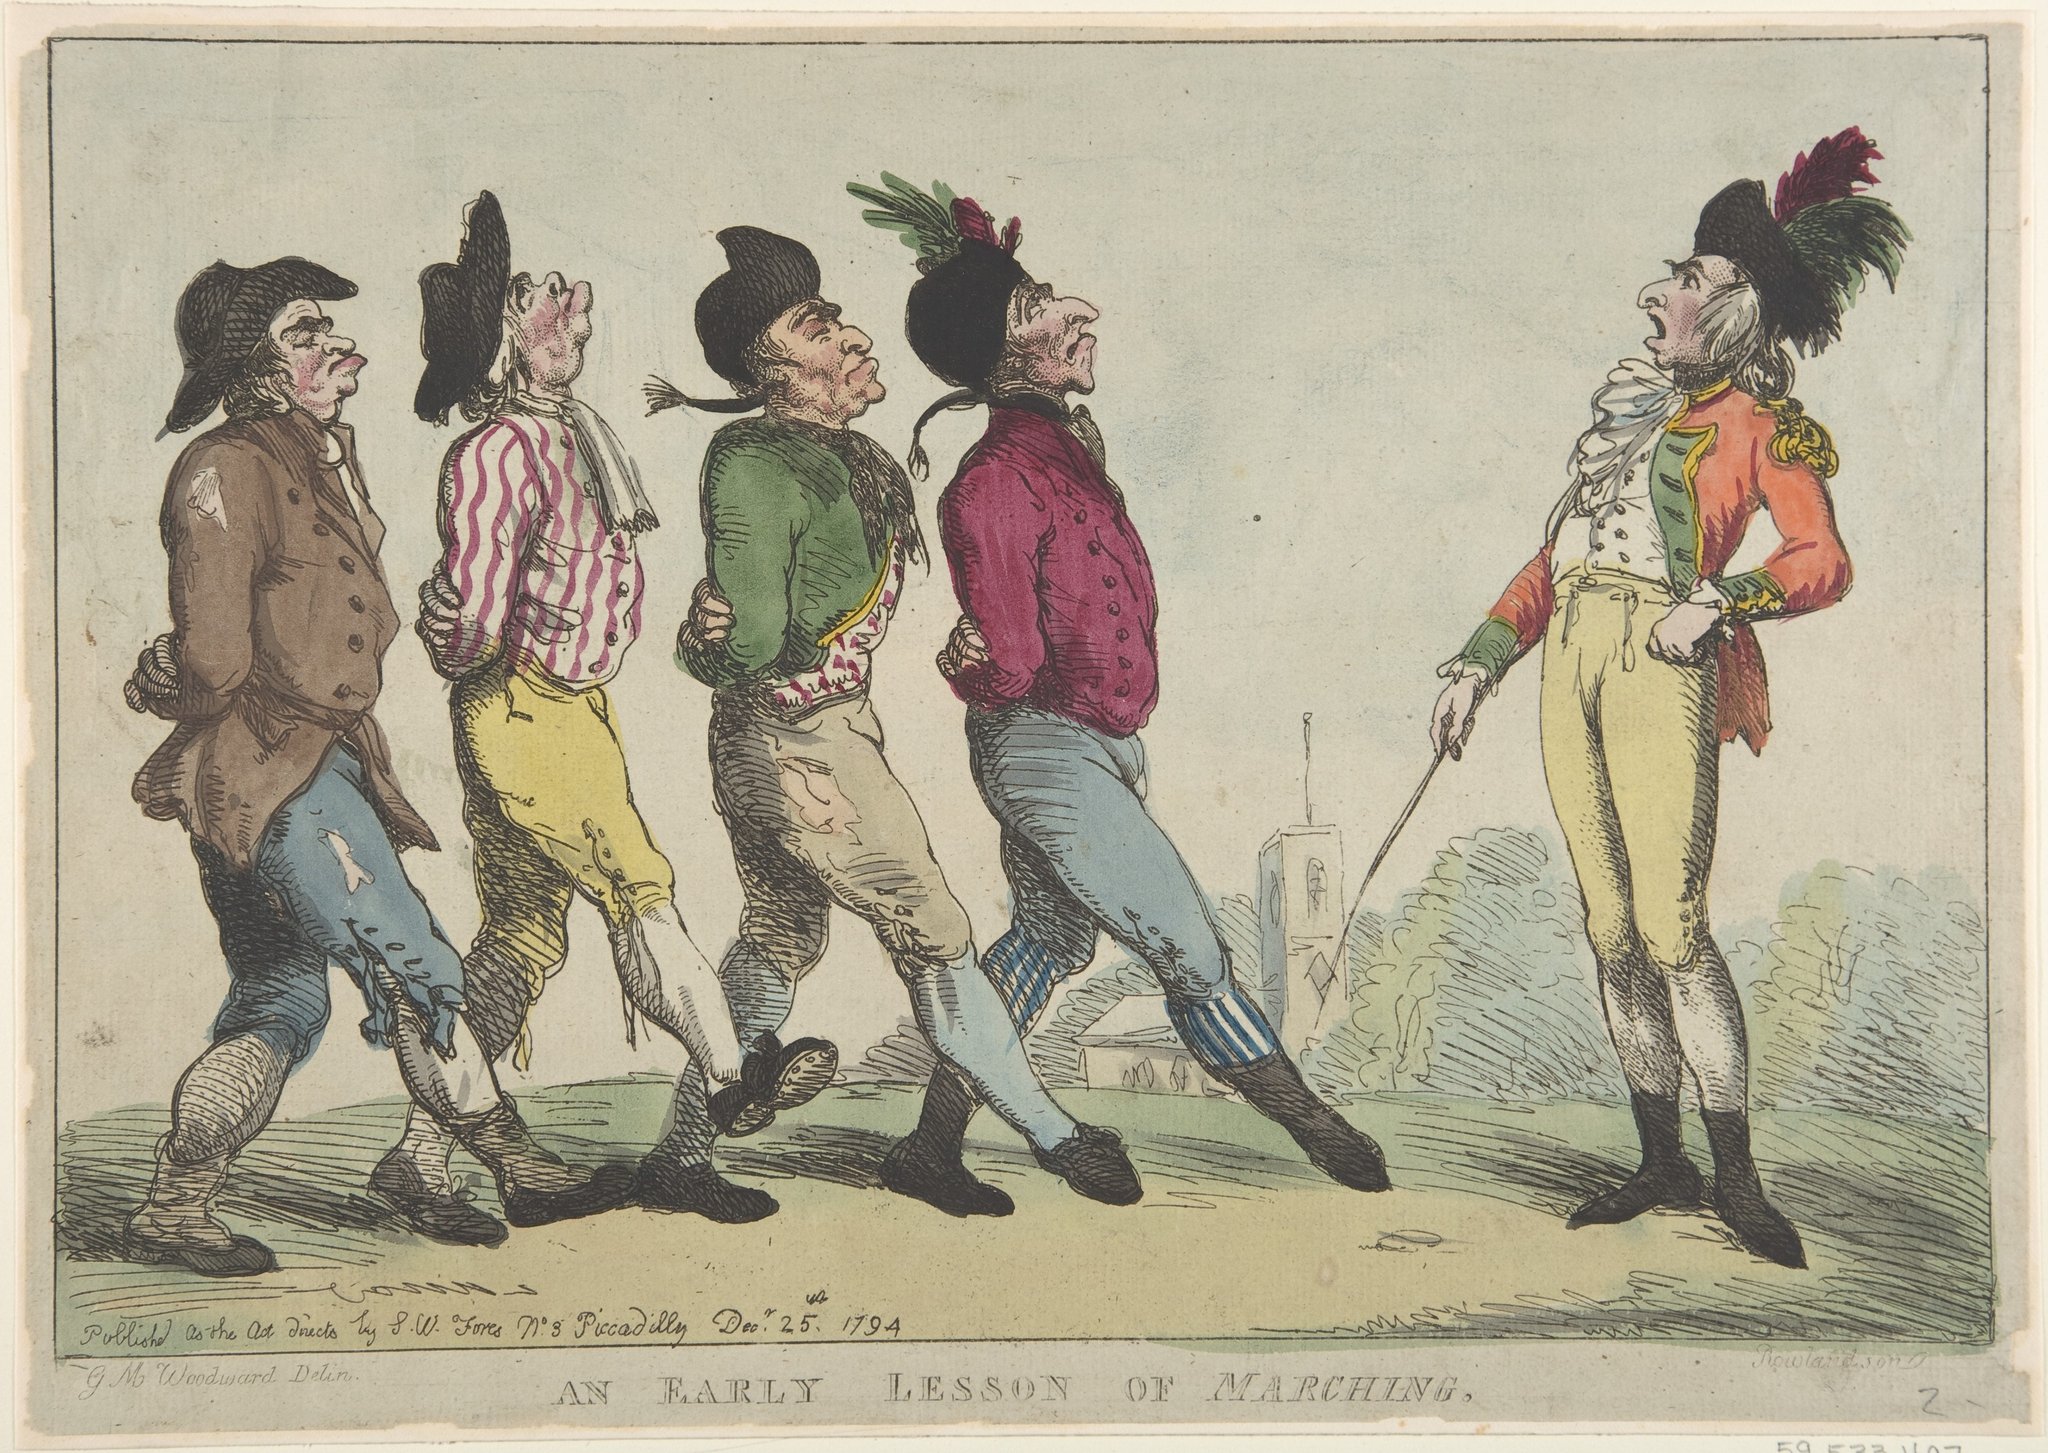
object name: print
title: An Early Lesson of Marching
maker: thomas rowlandson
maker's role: artist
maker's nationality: british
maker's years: 1757-1827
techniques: etching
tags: men